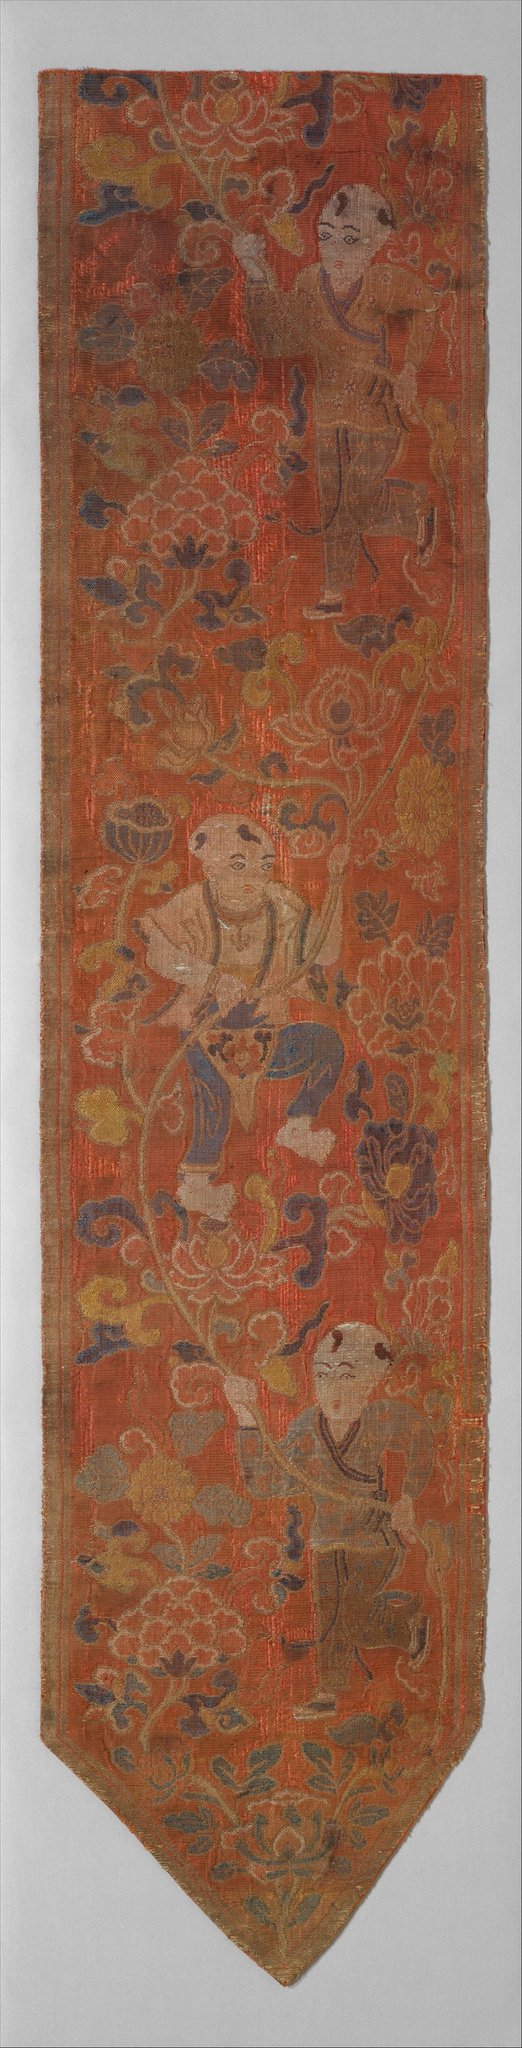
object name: textile pendant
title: Vertical pendant with boys holding a lotus scroll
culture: chinese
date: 1201-1400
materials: textile, metal thread, silk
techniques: patterning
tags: scrolls,boys,lotuses